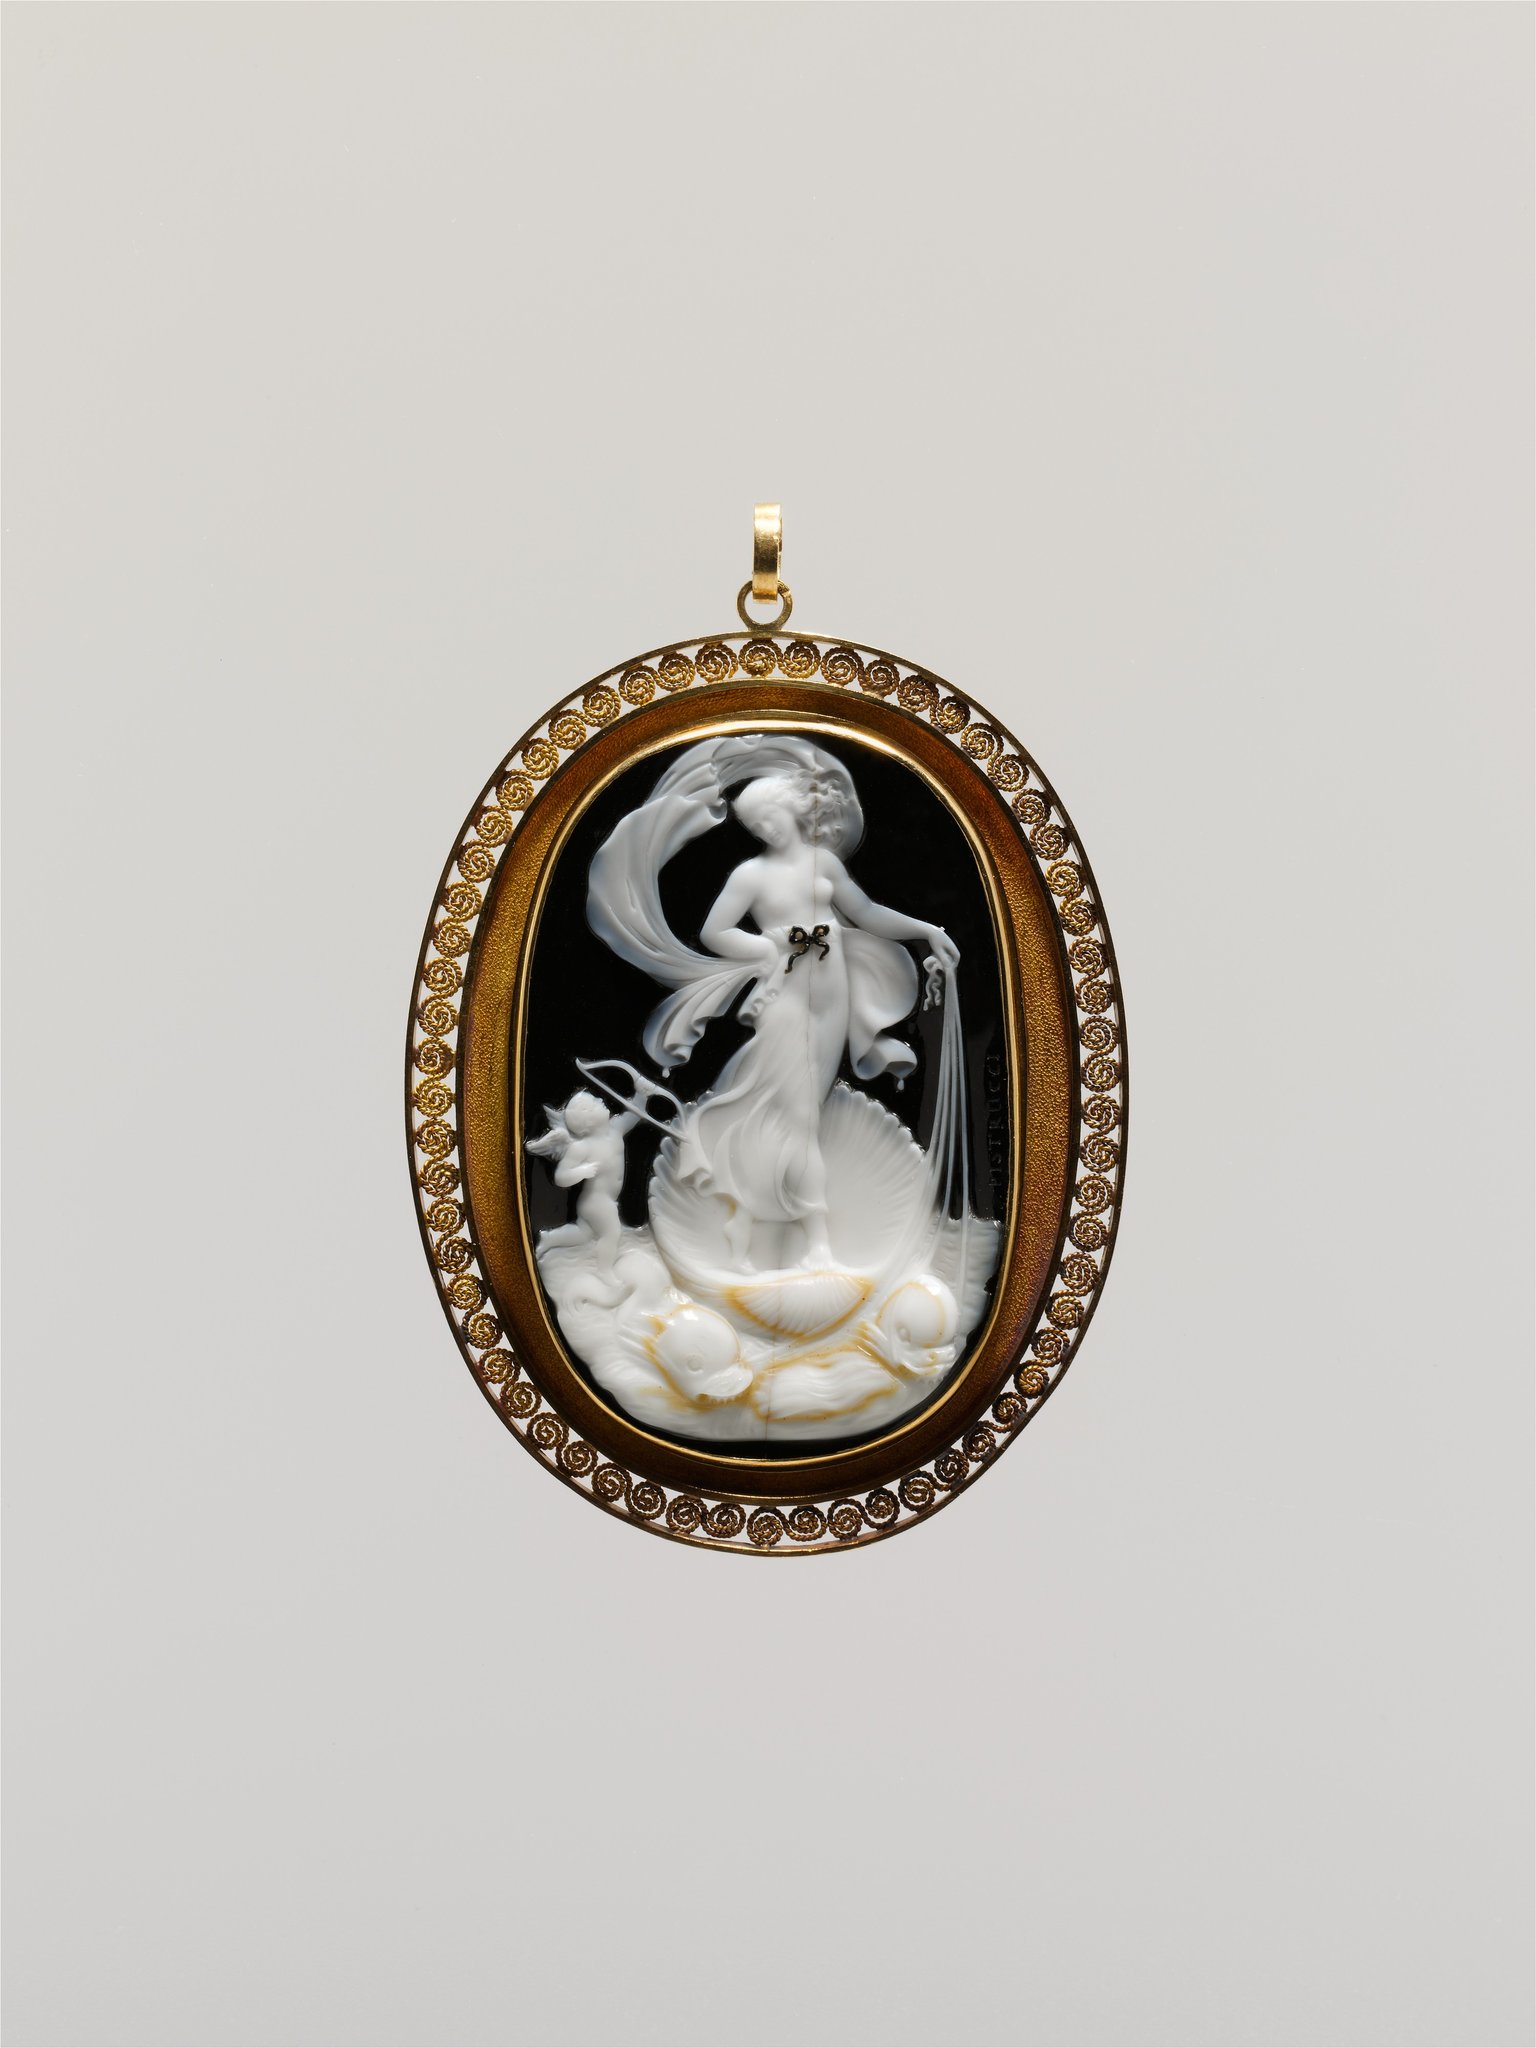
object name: cameo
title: Venus Marina, Cupid at Her Side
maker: benedetto pistrucci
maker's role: artist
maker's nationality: italian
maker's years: 1783-1855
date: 1820-1830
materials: gold, onyx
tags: cupid,venus